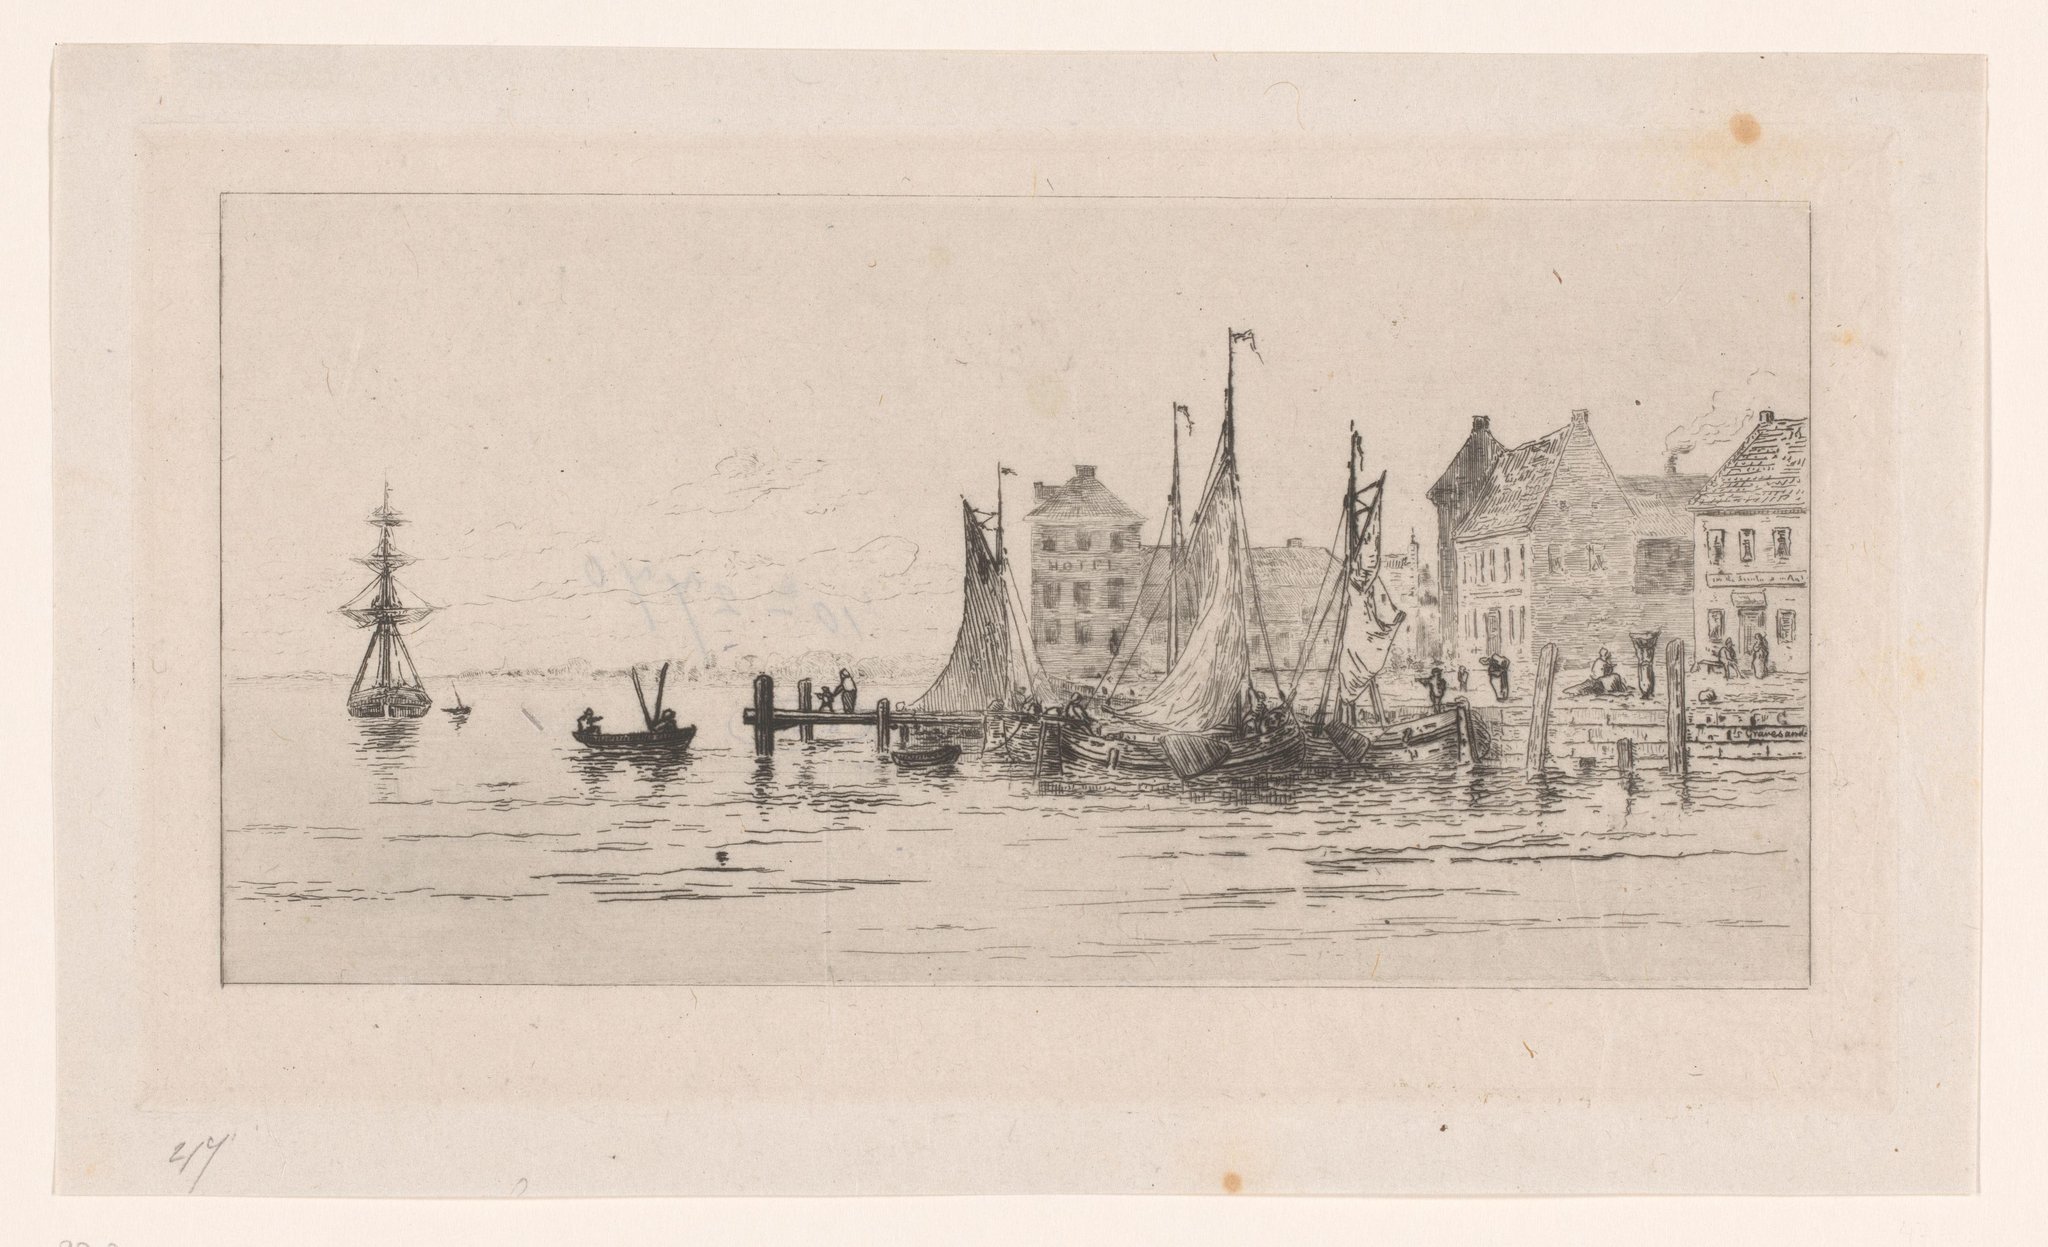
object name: print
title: Tamise sur l'Escaut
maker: carel nicolaas storm van s-gravesande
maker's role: draughtsman, print maker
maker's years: 1841-1924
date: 1880-1884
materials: paper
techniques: etching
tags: harbour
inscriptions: collector's mark: Lugt 2228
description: Gezicht op een haven waar zeilboten afgemeerd liggen. Rechts de kade; links vaart een zeilschip op de Schelde.